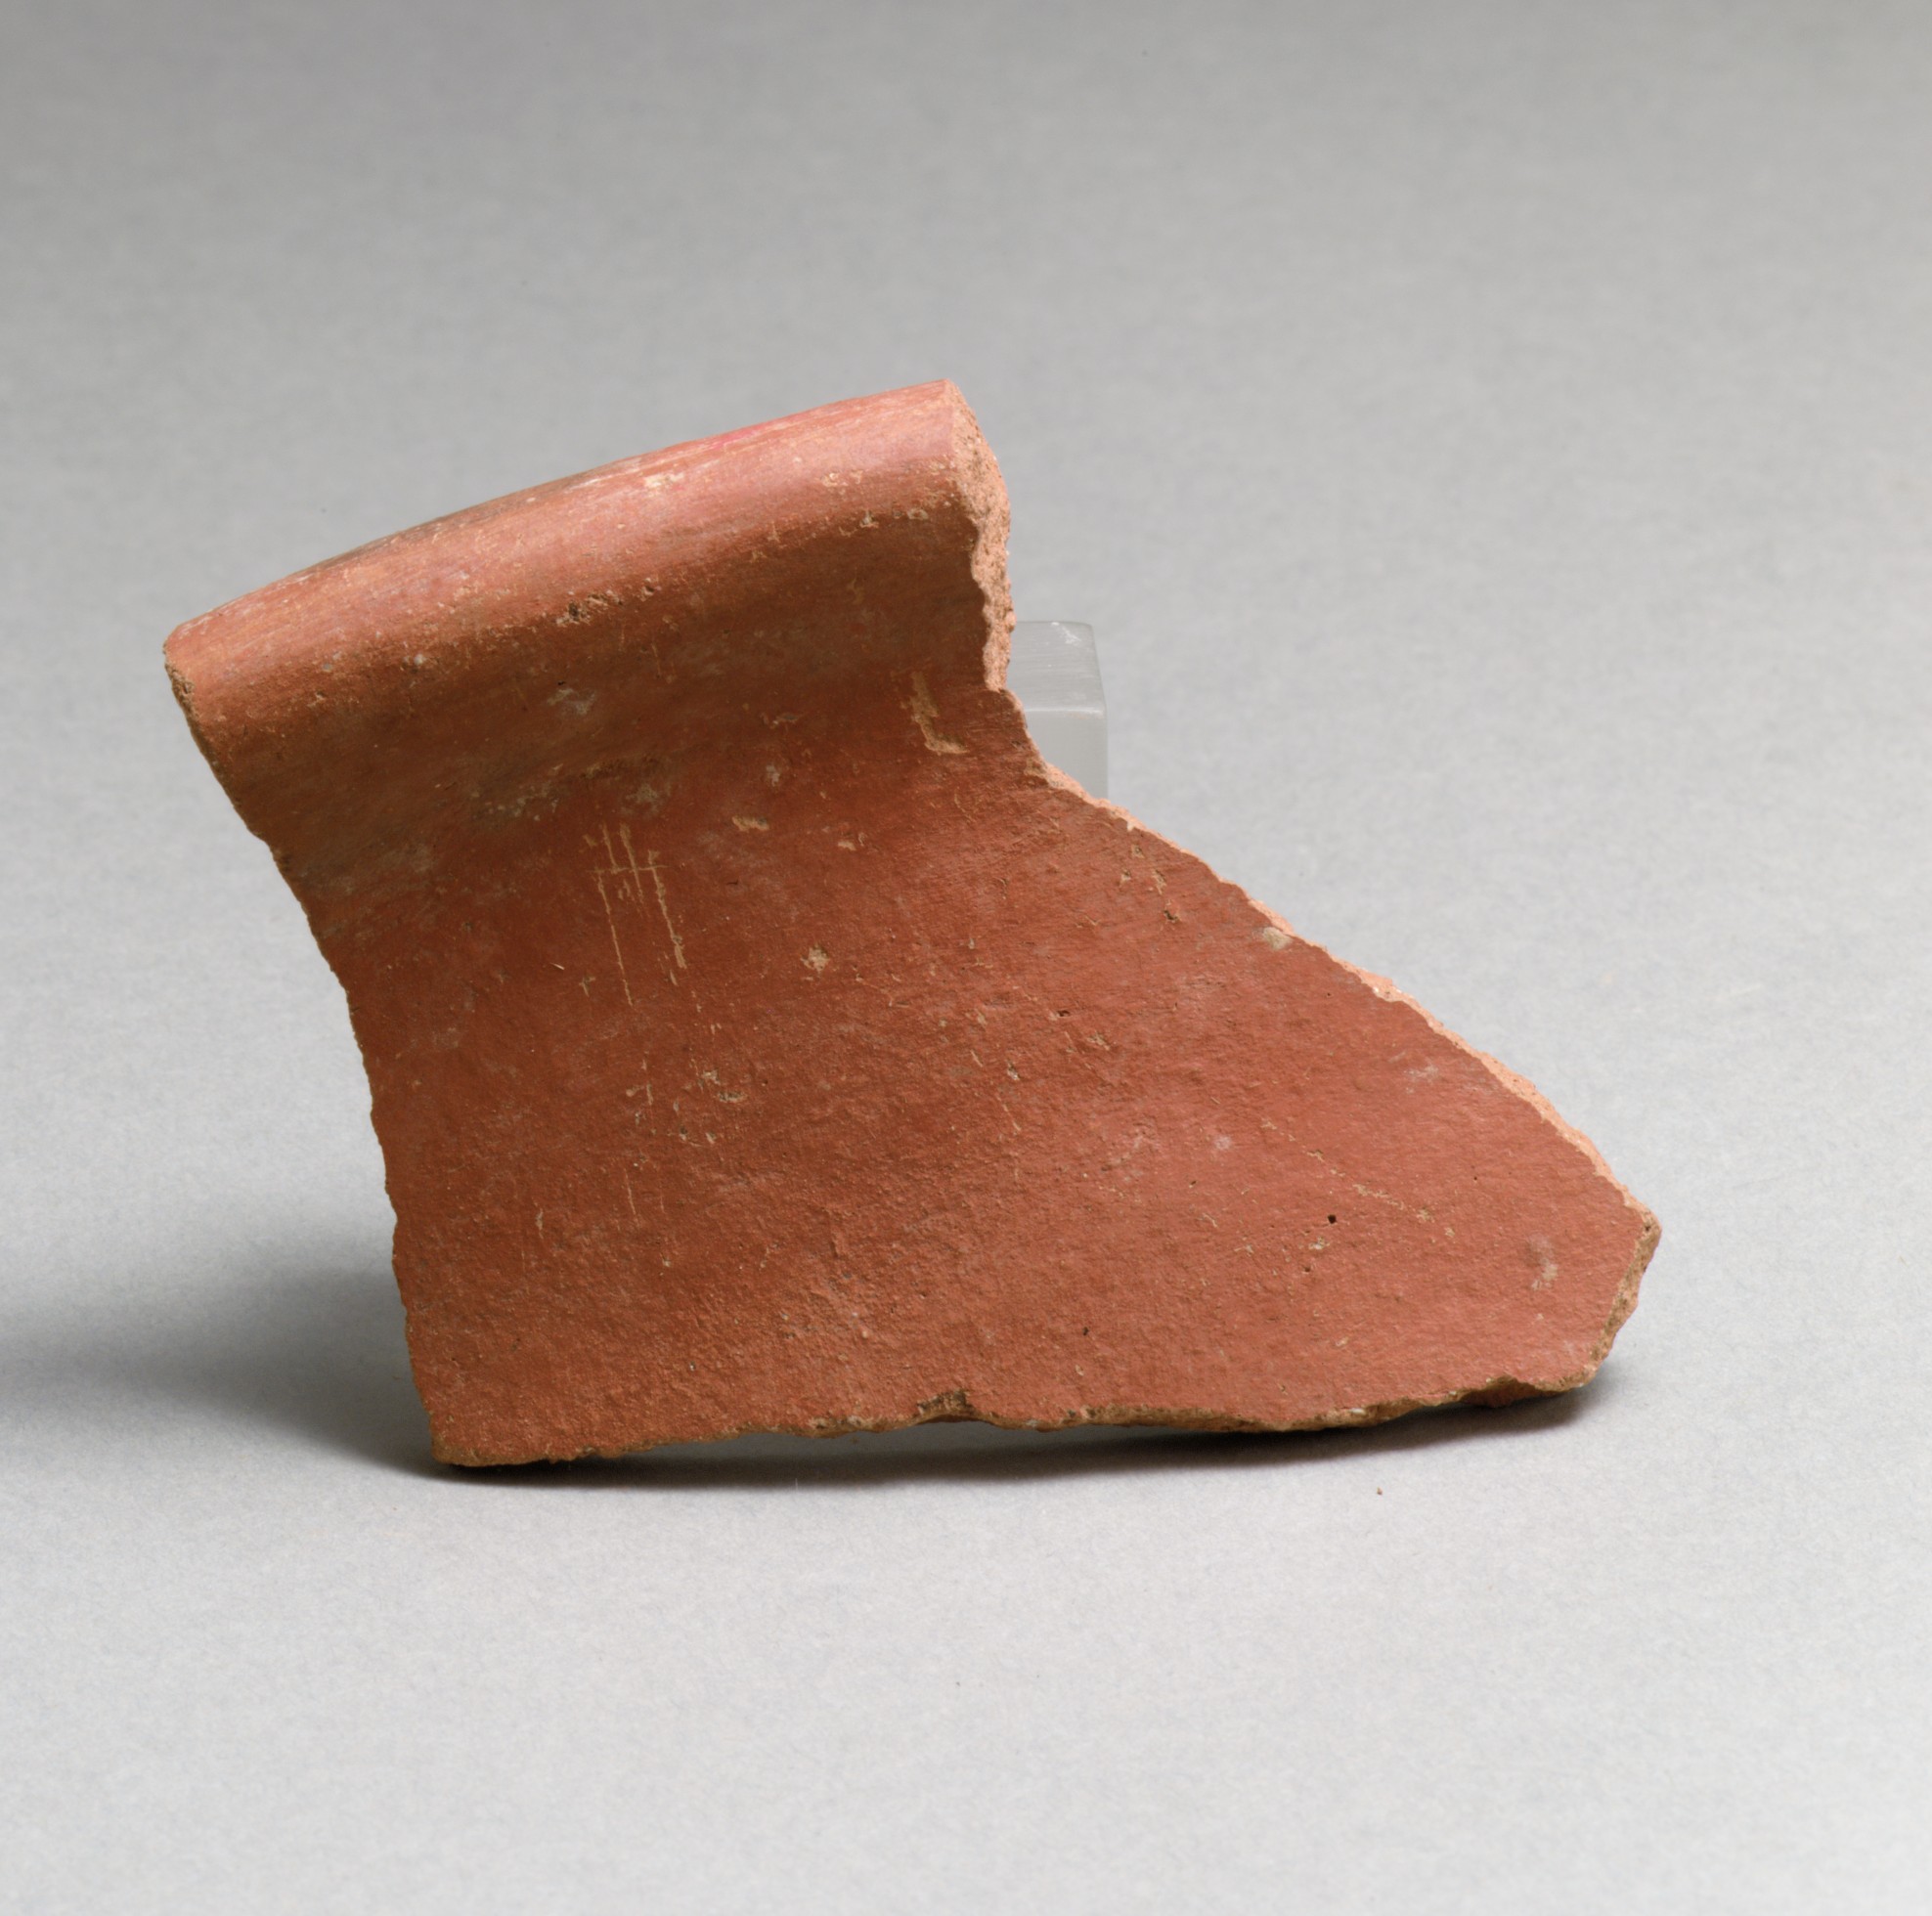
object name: vase fragment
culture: minoan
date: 2600-2000 BCE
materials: terracotta